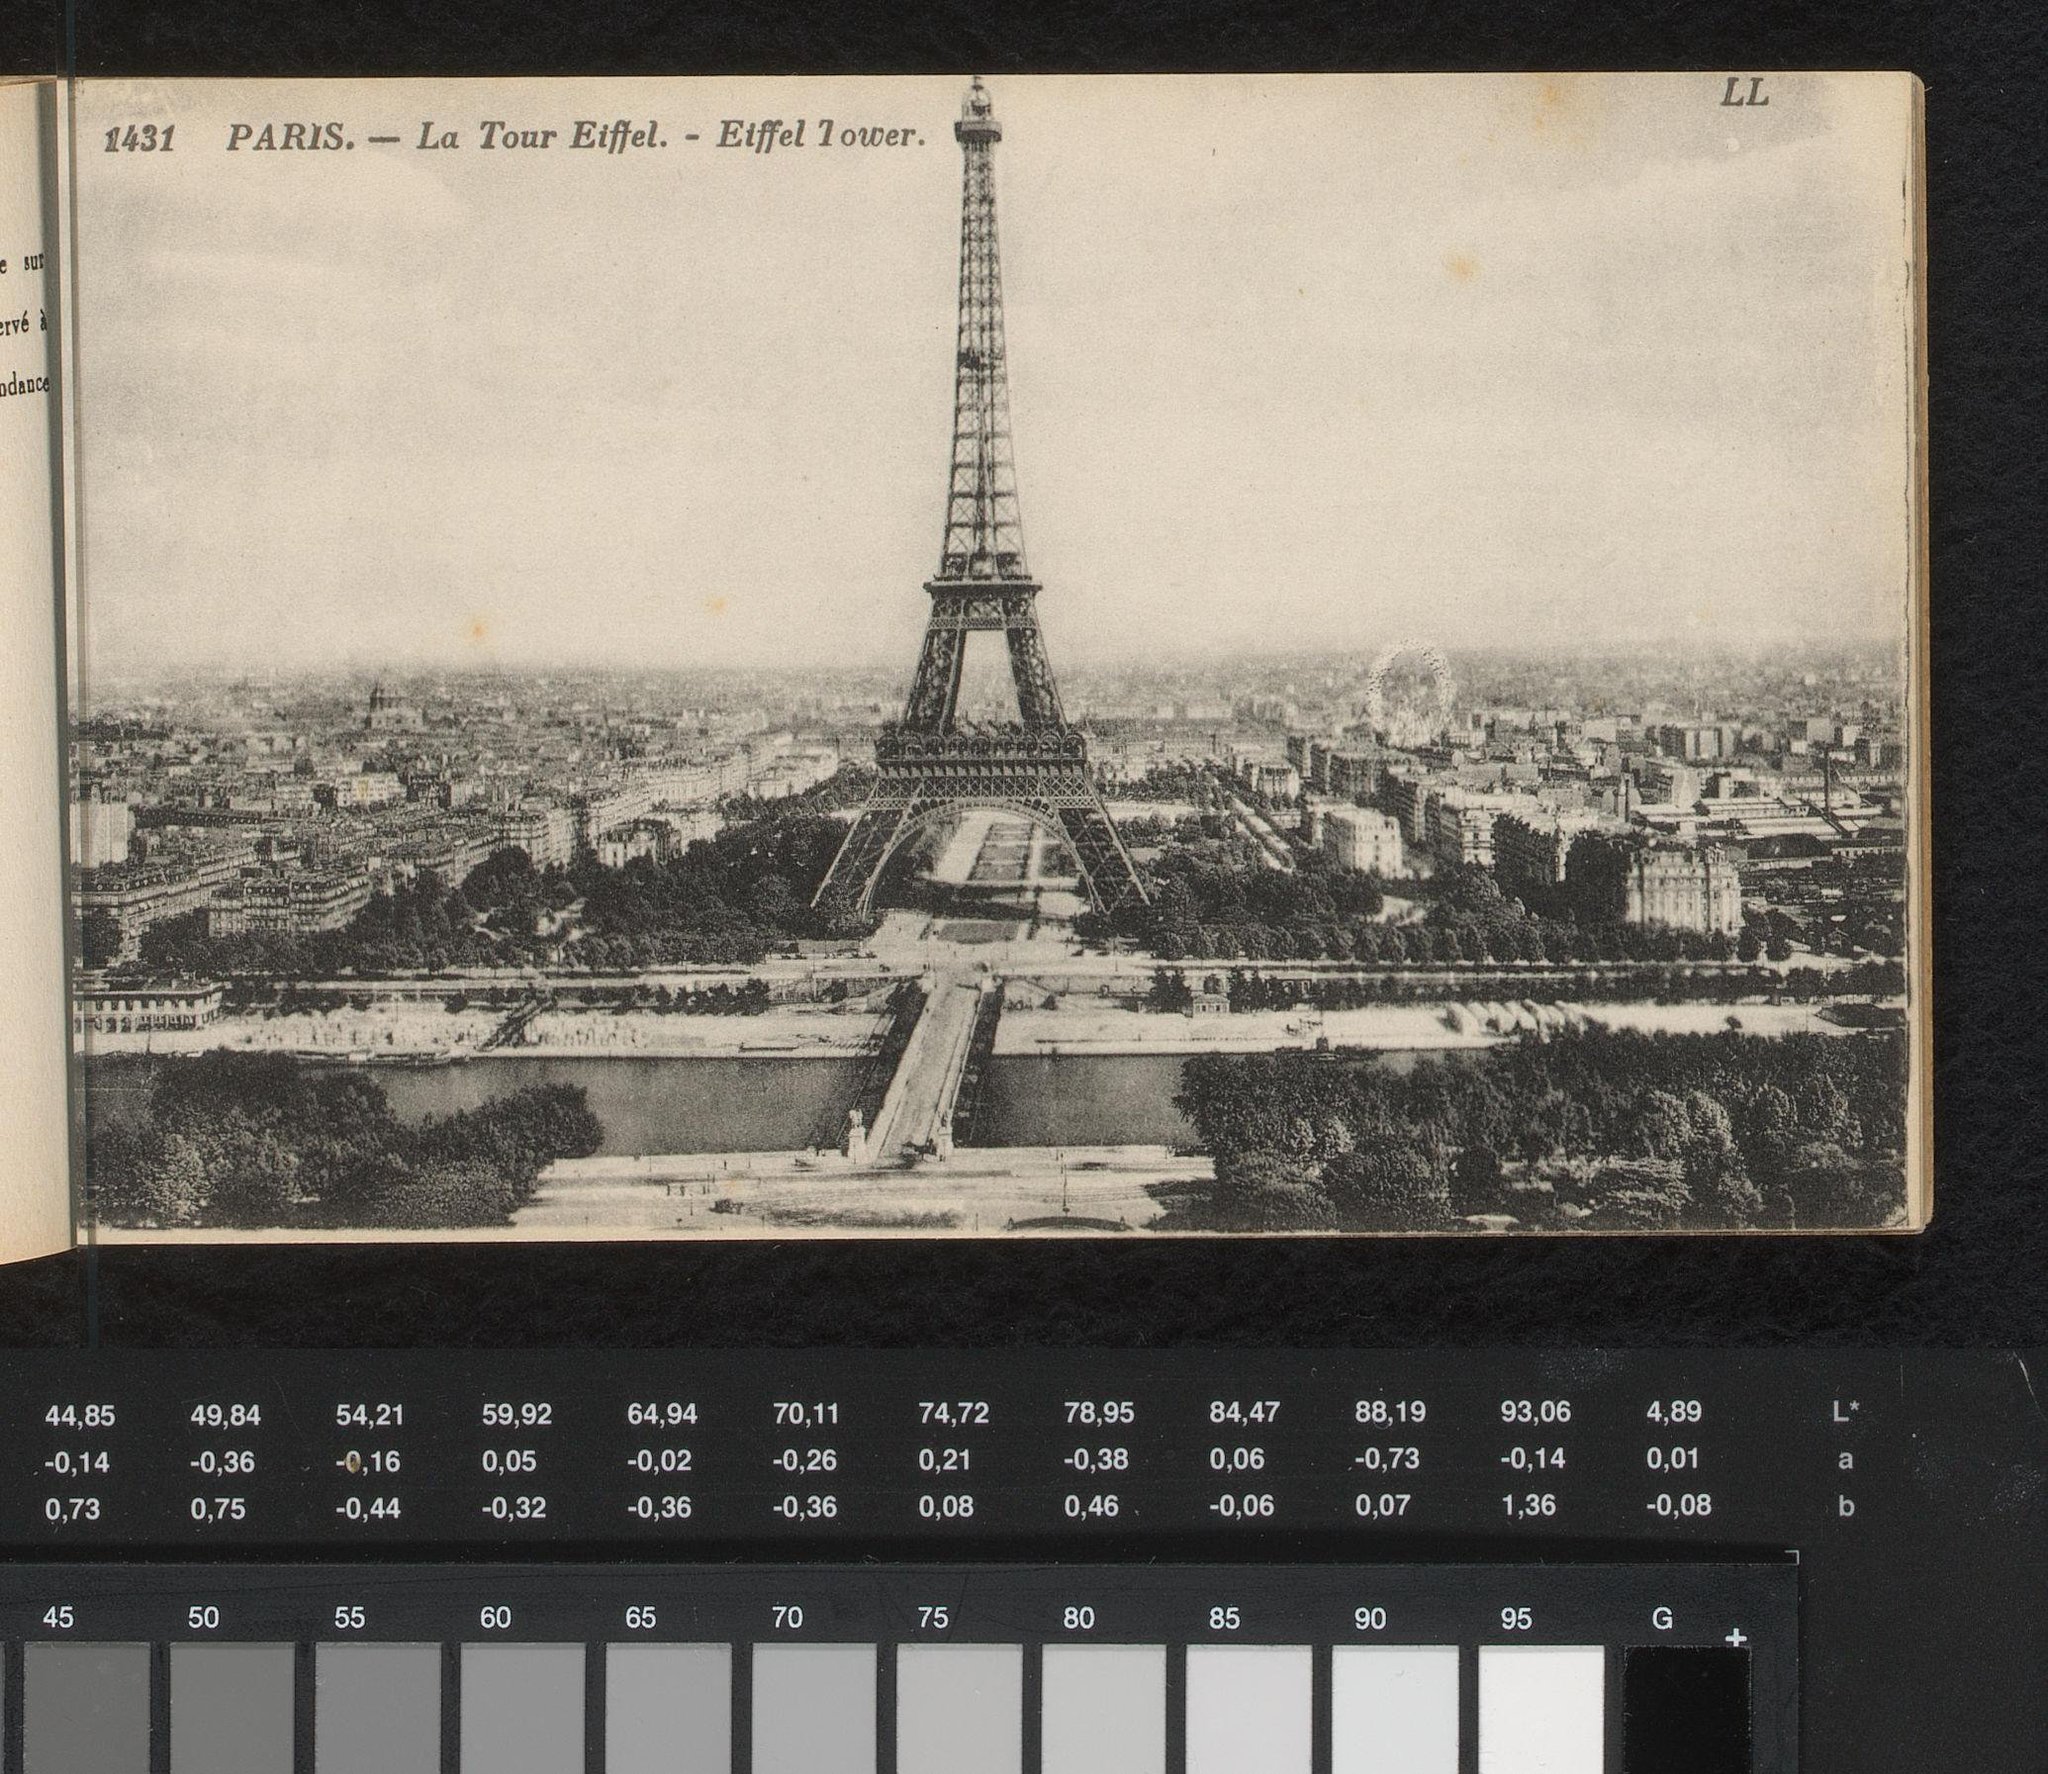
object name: photomechanical print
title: Paris. La Tour Eiffel / Eiffel Tower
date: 1920-1932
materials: cardboard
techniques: photograph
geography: paris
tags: tower, clock tower ~ monumental adornment, river, prospect of city, town panorama, silhouette of city, eiffel tower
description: Prentbriefkaart maakt deel uit van een album.